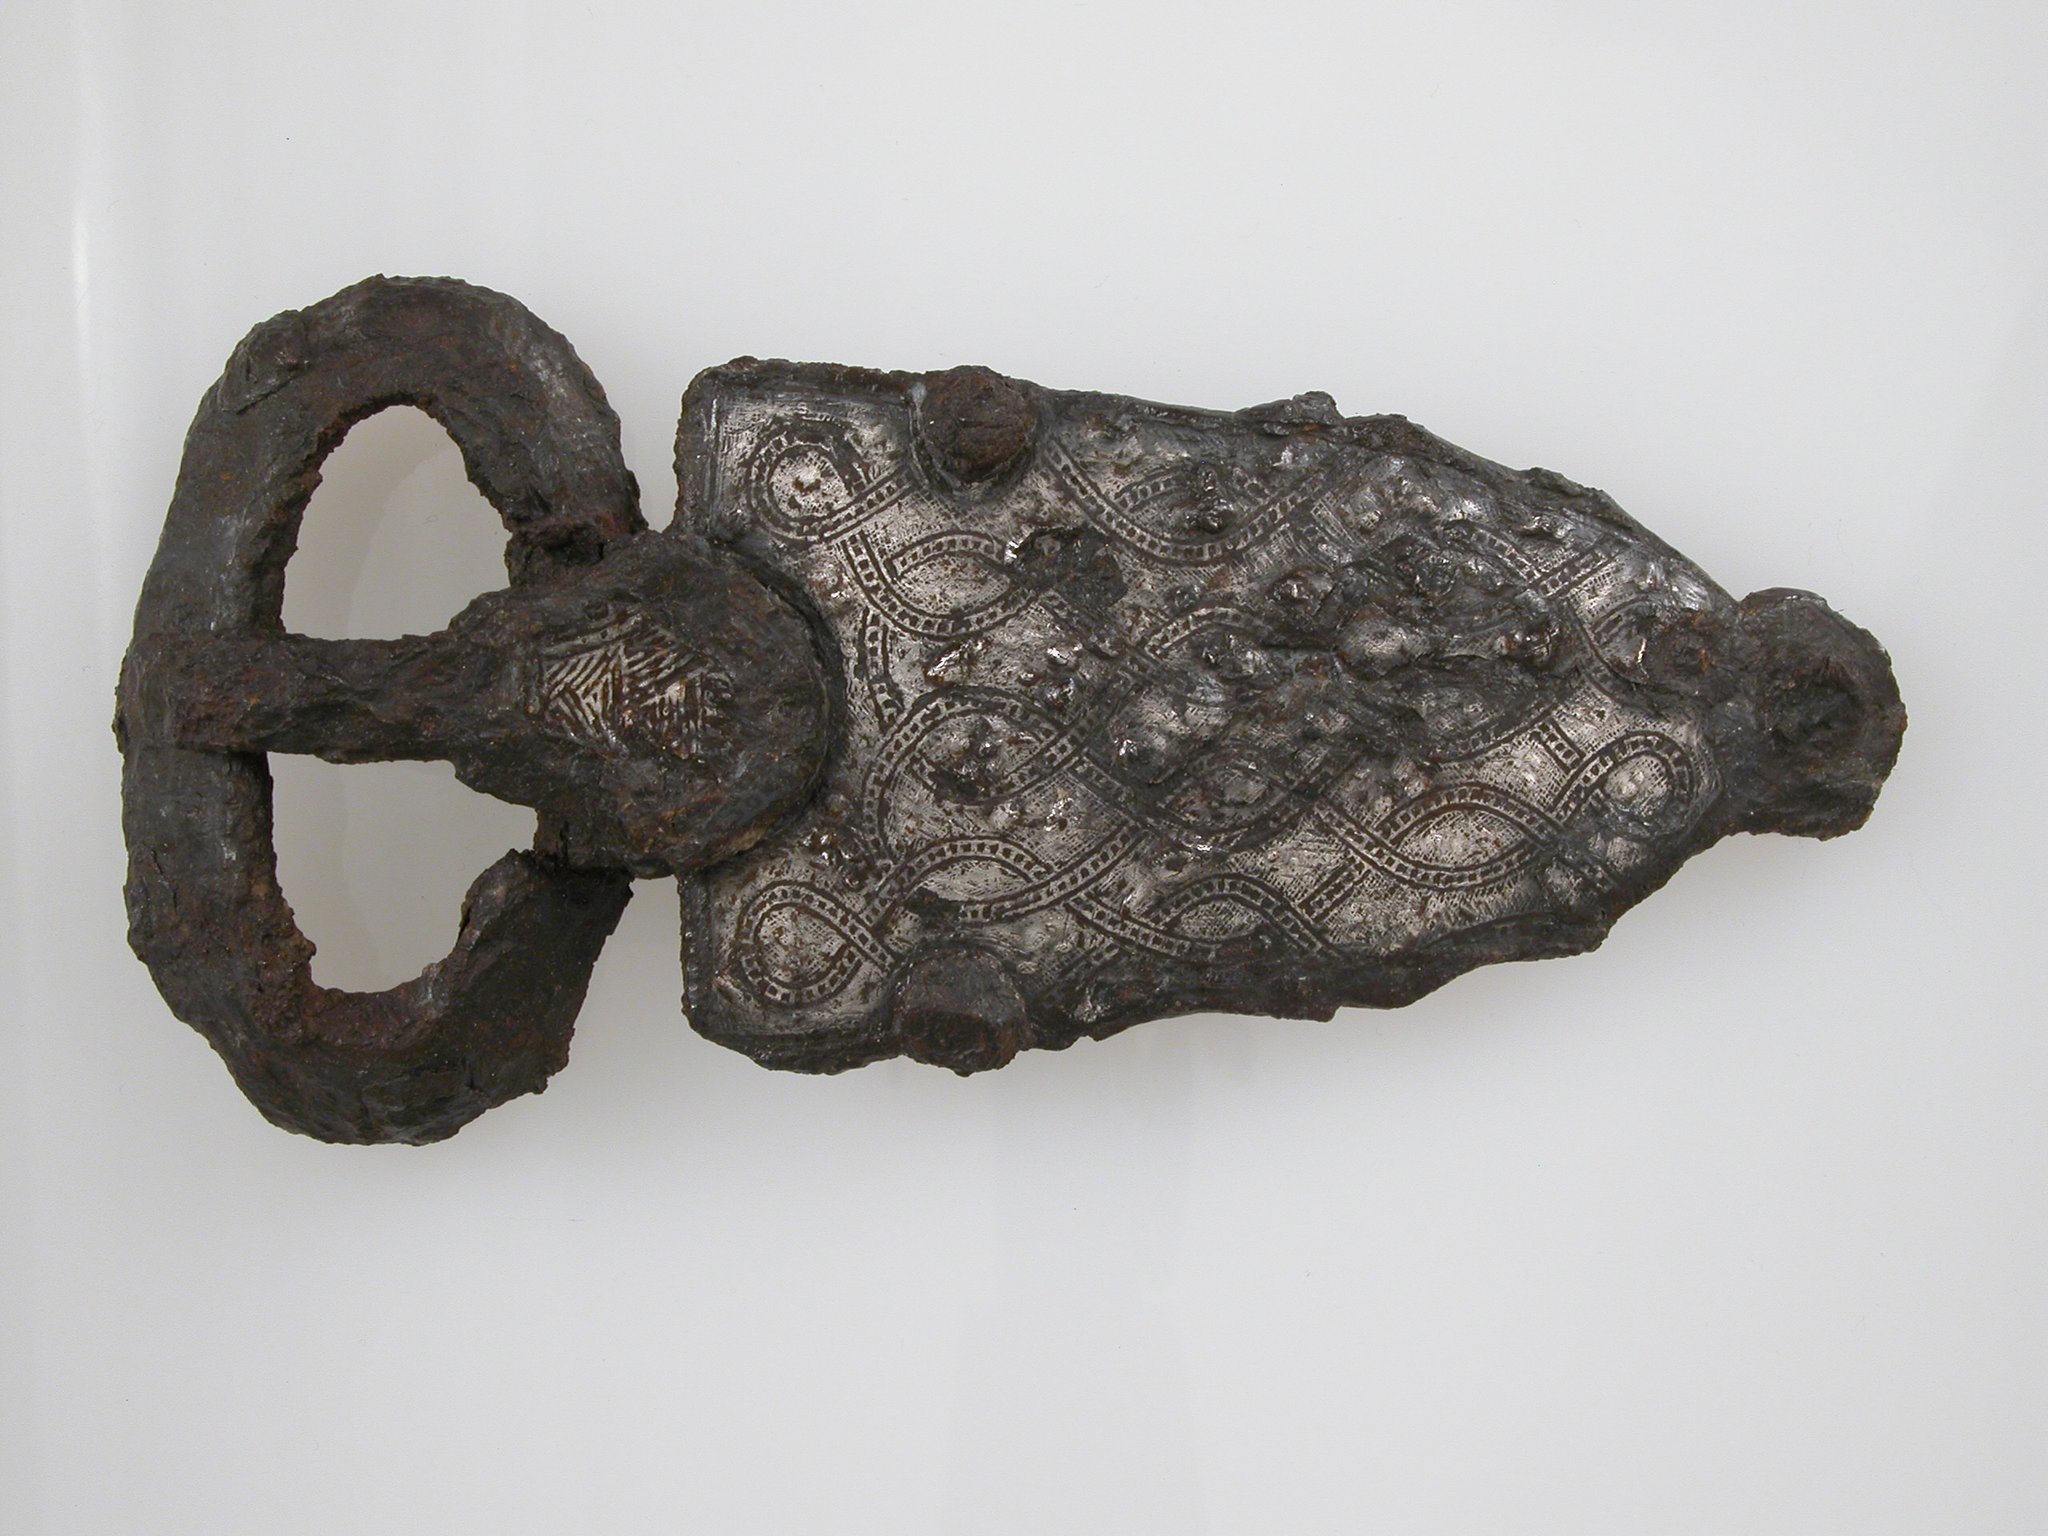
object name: belt buckle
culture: burgundian or frankish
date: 601-700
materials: bronze, iron, silver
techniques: inlay